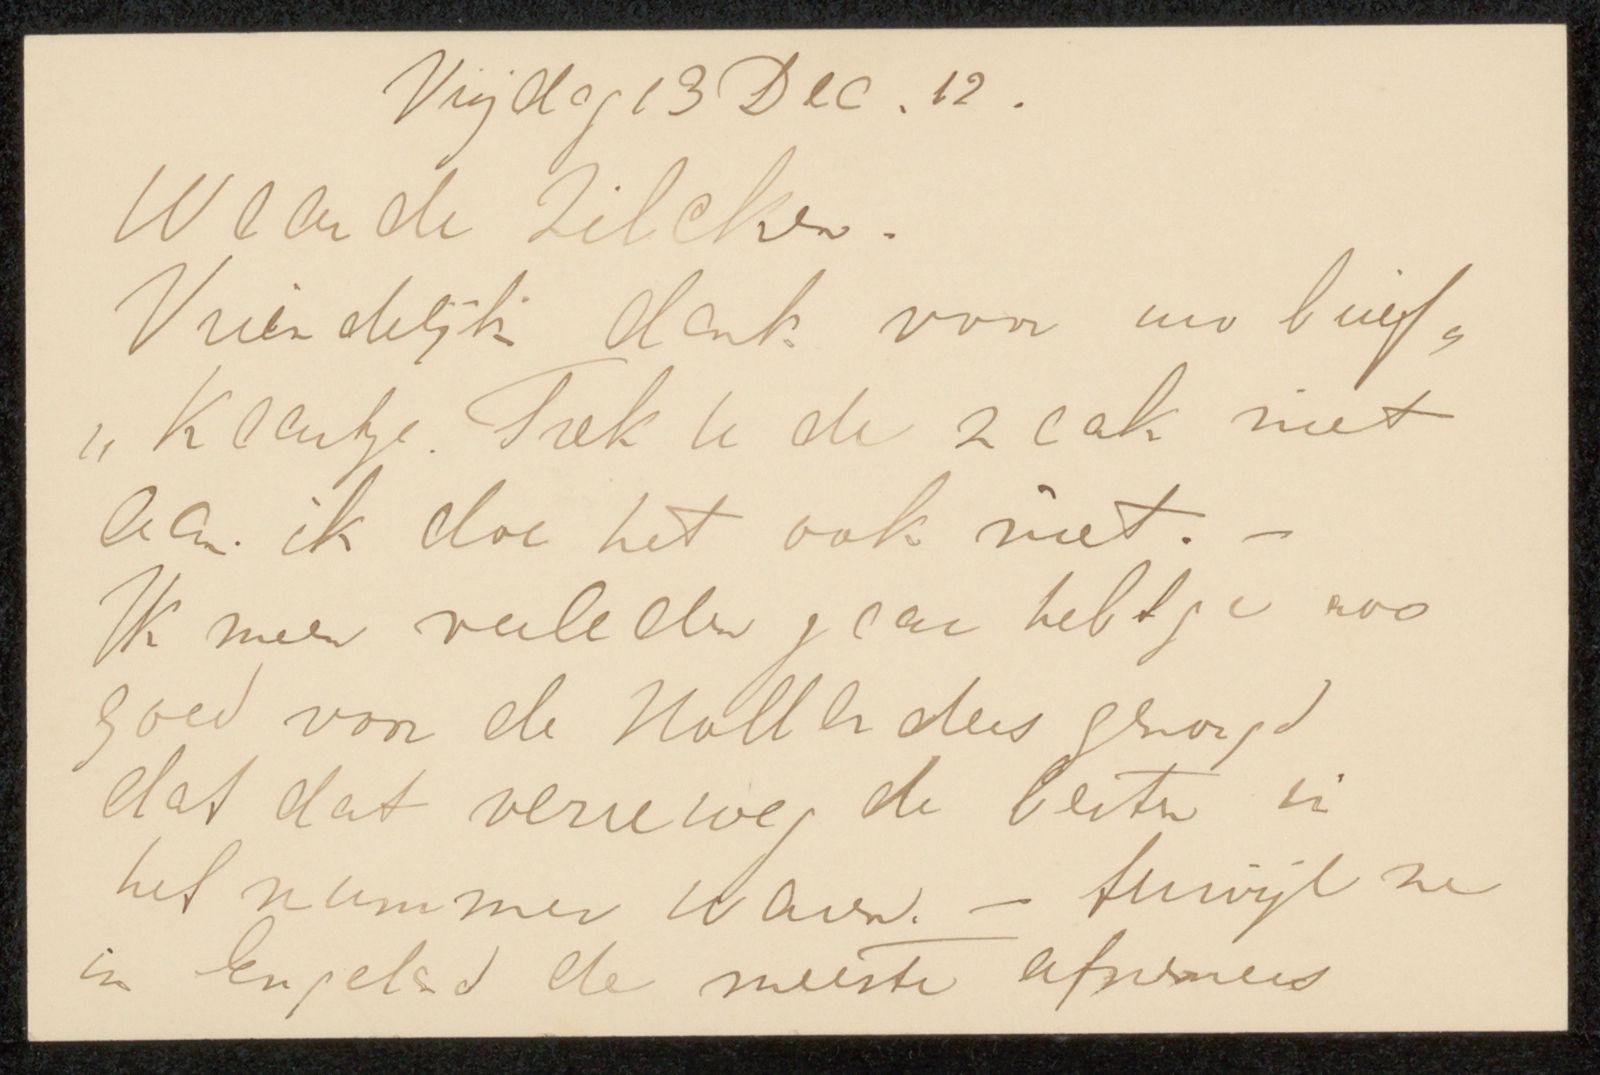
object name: letter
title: Brief aan Philip Zilcken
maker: barbara elisabeth van houten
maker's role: draughtsman, print maker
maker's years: 1862-1950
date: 1912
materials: cardboard, ink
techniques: pen, writing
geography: the hague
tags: painter, philip zilcken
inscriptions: collector's mark: ‘RPK’